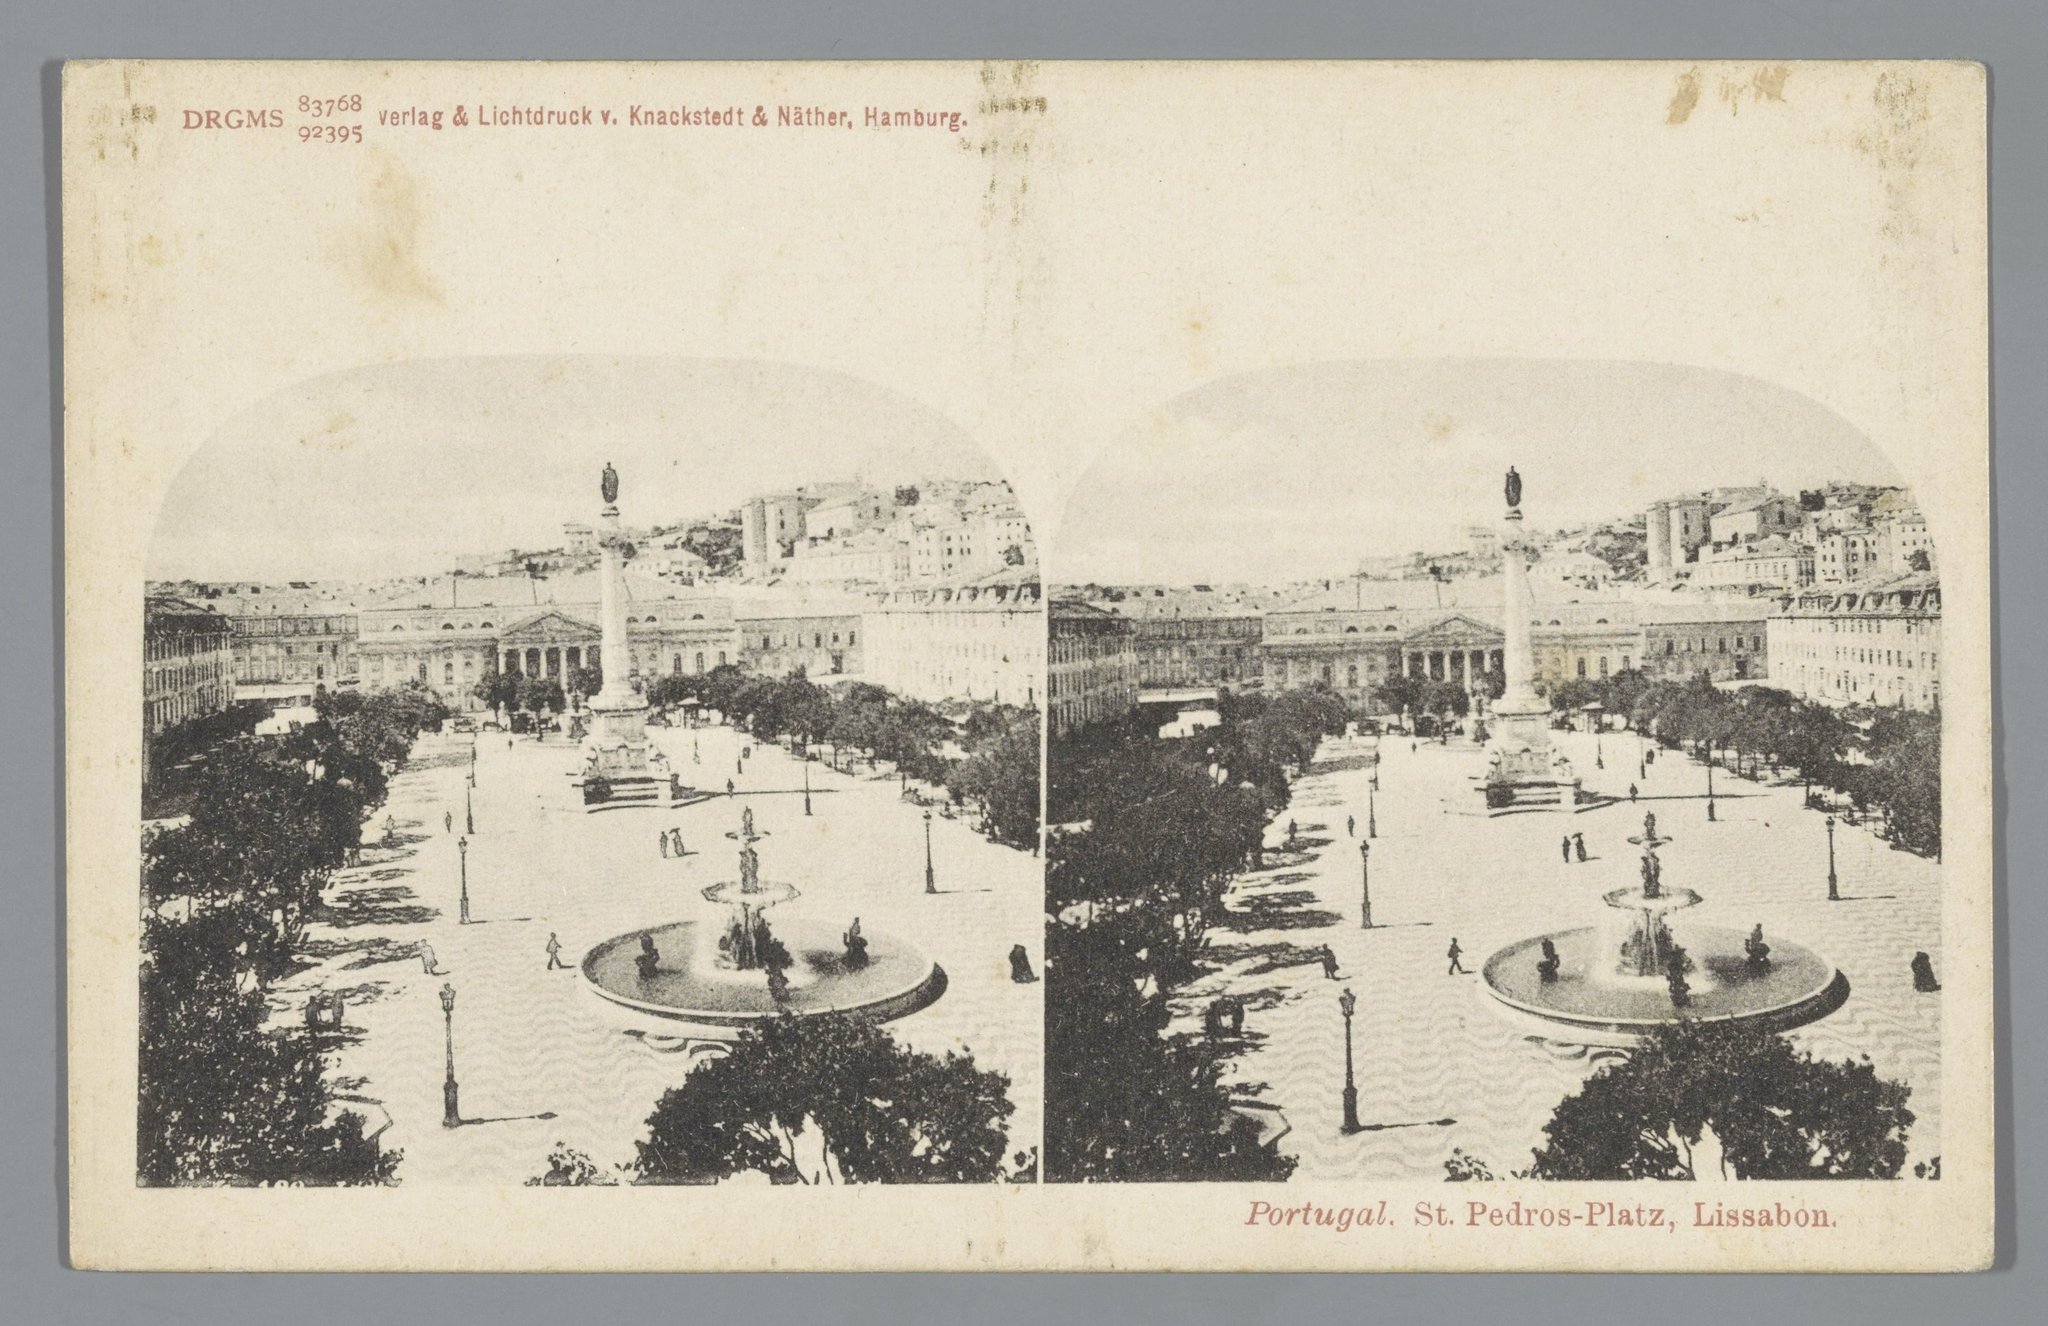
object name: stereograph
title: Portugal. St. Pedros-Platz, Lissabon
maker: Anonymous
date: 1889-1905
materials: cardboard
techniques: photograph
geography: lisbon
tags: square, place, circus, etc.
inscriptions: inscription: ‘Postkarte’, inscription: ‘DRGMS 83768/ 92395’